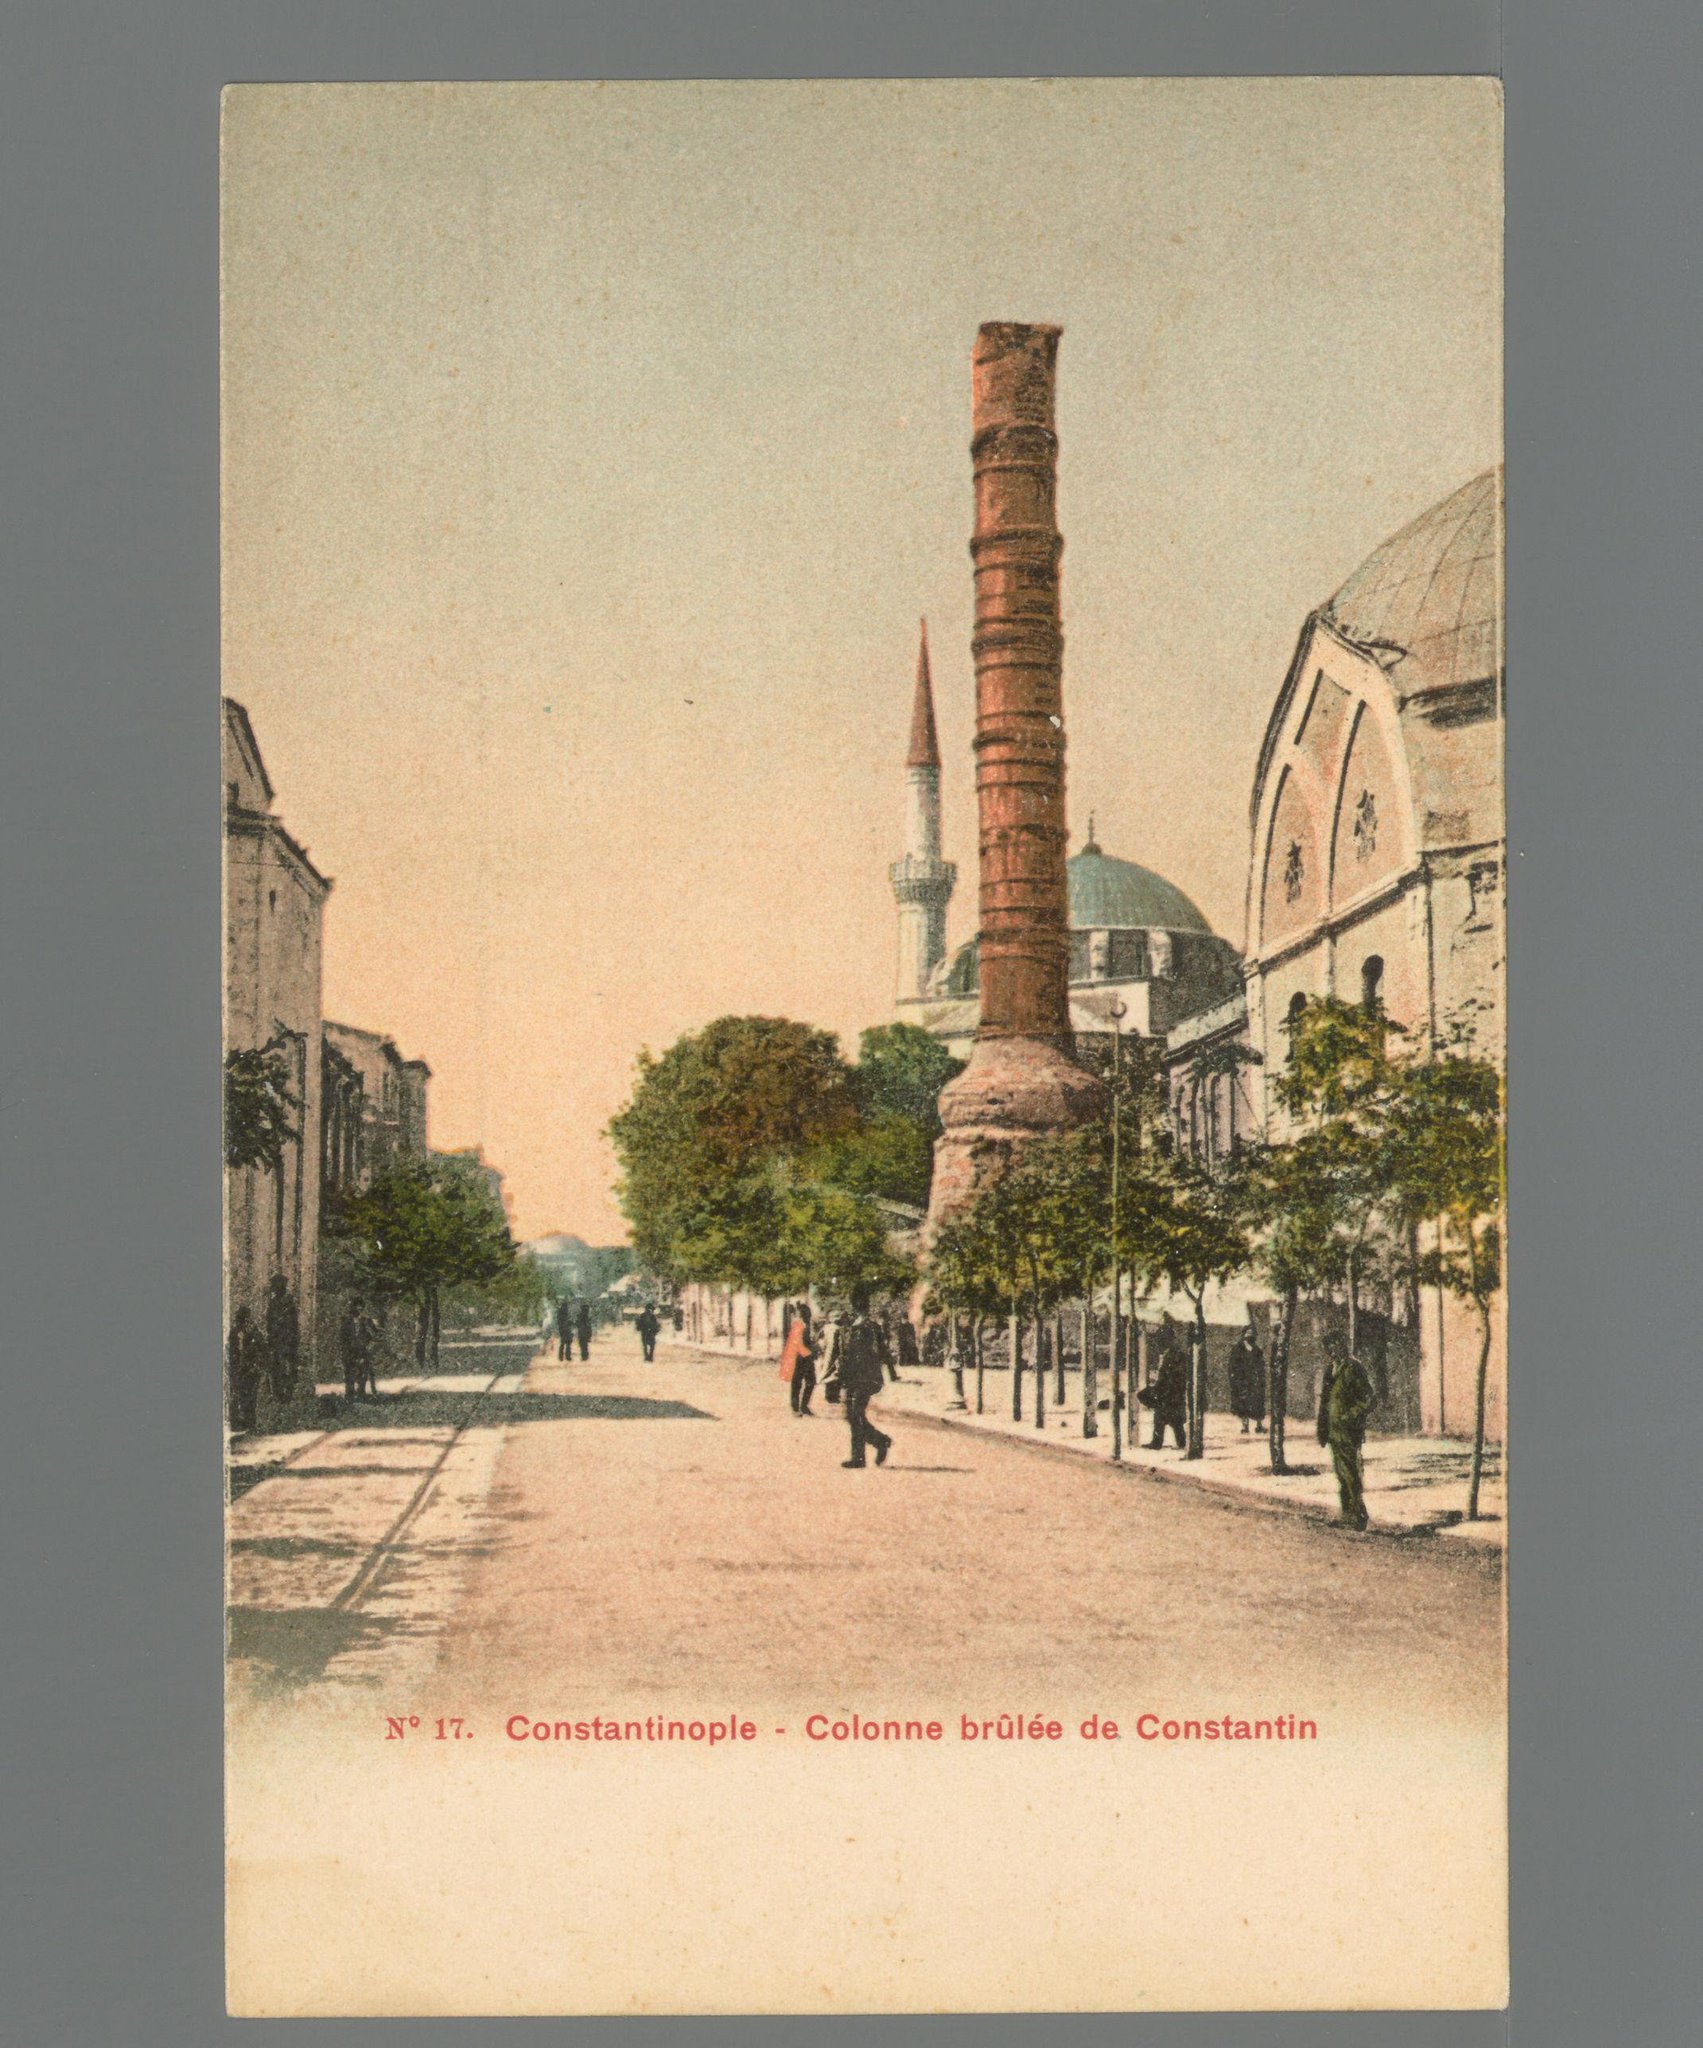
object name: ansichtkaart, prentbriefkaart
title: Constantinople. Colonne brûlée de Constantin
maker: Anonymous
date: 1898-1905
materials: cardboard, photographic process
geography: constantinople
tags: triumphal column with helical friezes, temple, shrine ~ islam, mohammedanism, city-view, and landscape with man-made constructions (+ city(-scape) with figures, staffage)